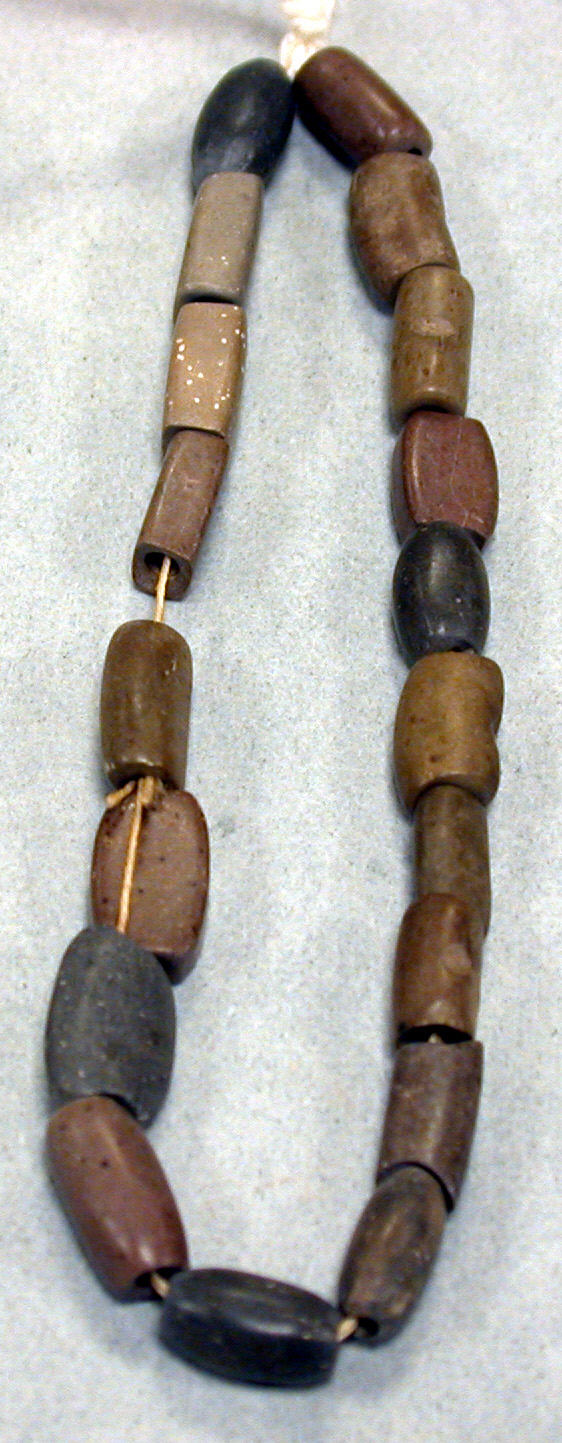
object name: bead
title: Necklace of Stone Beads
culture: peruvian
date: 1-1566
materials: stone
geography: peru